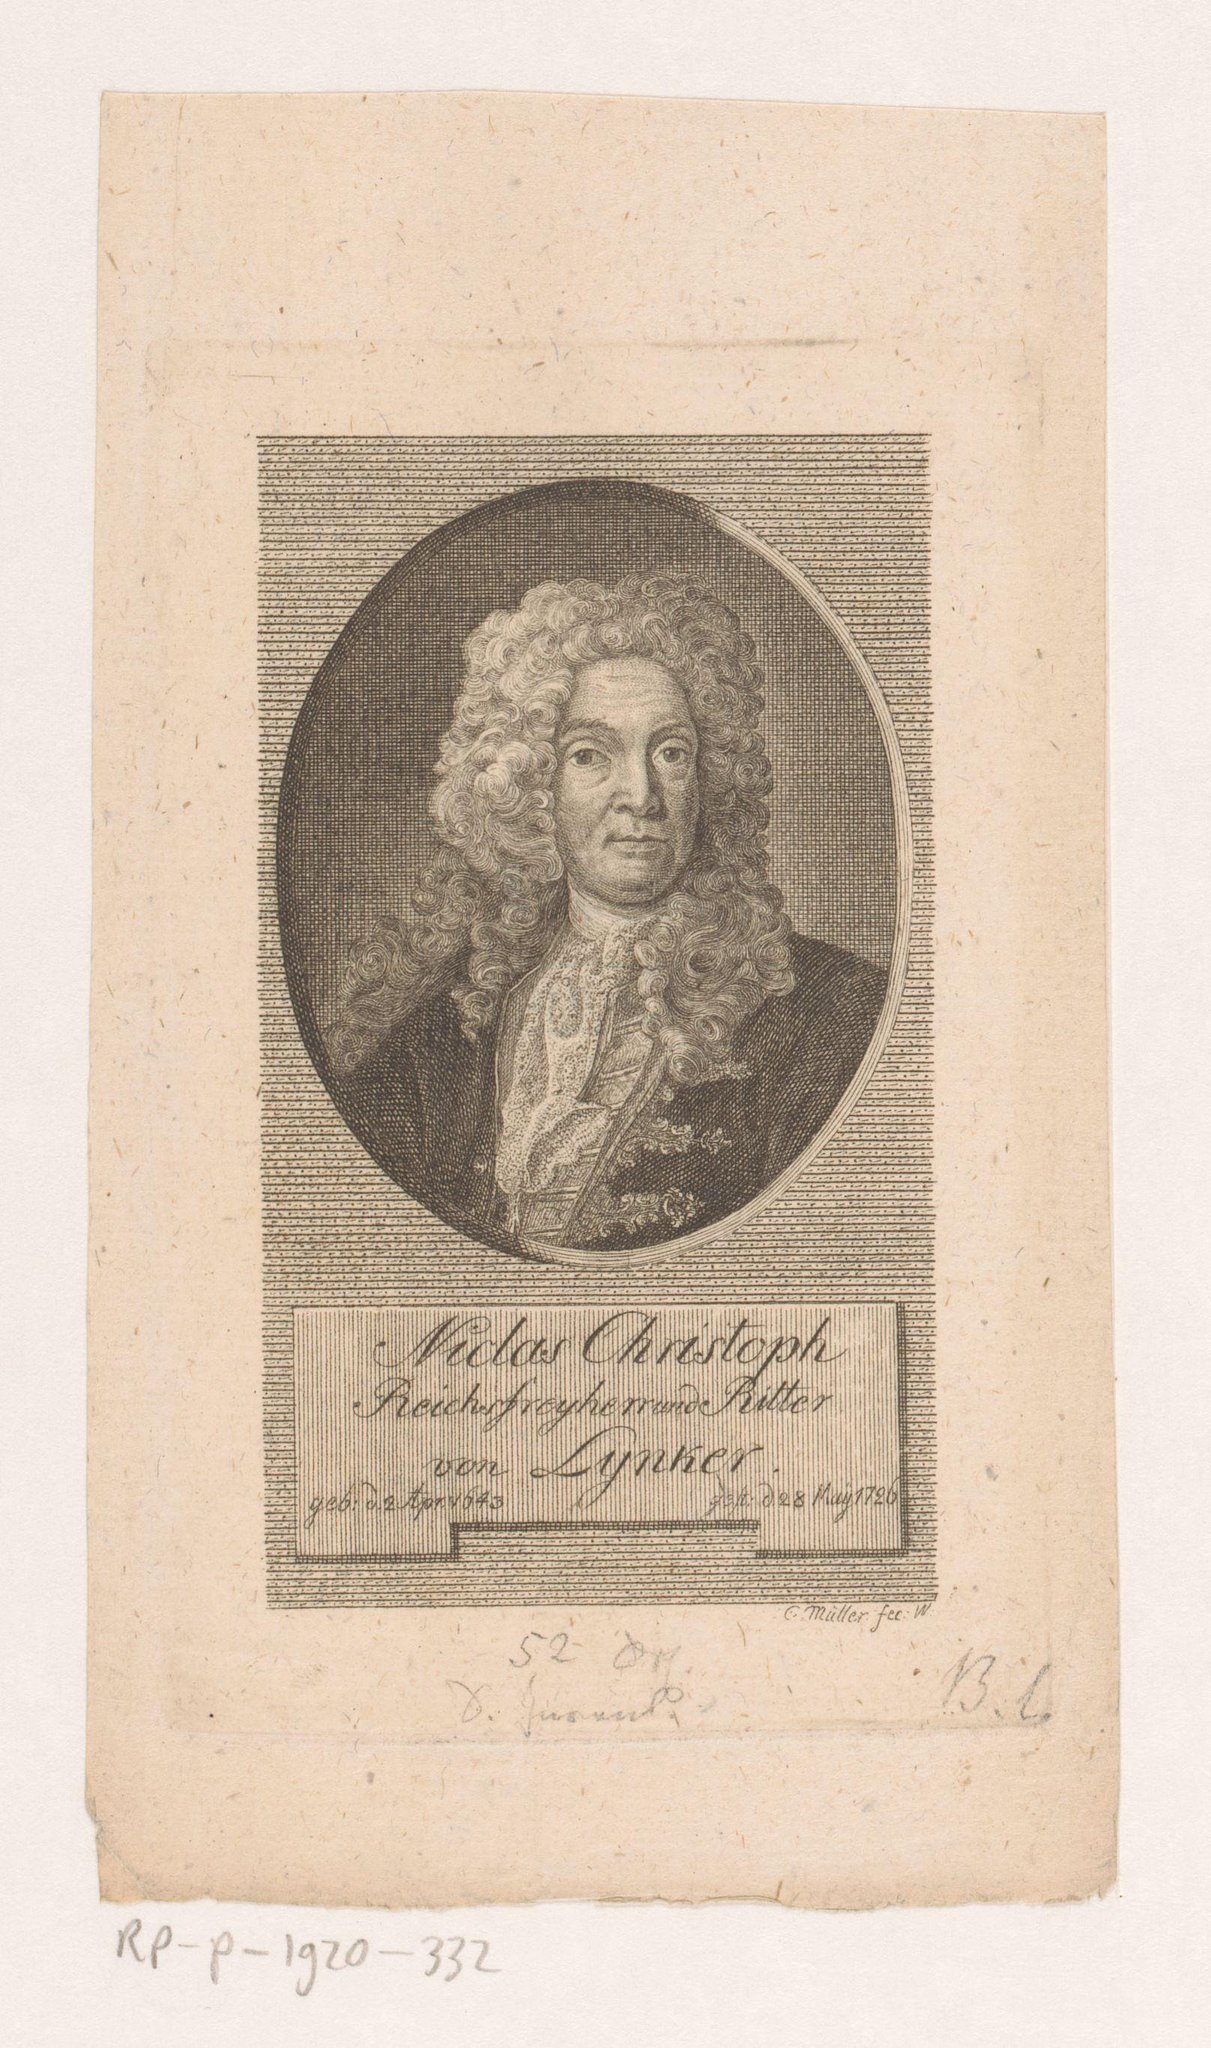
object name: print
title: Portret van Nicolaus Christoph Lunker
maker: johann christian ernst müller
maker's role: draughtsman, print maker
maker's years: 1766-1824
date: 1776-1824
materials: paper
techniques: etching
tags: vienna, historical persons, wig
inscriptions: collector's mark: Lugt 2228